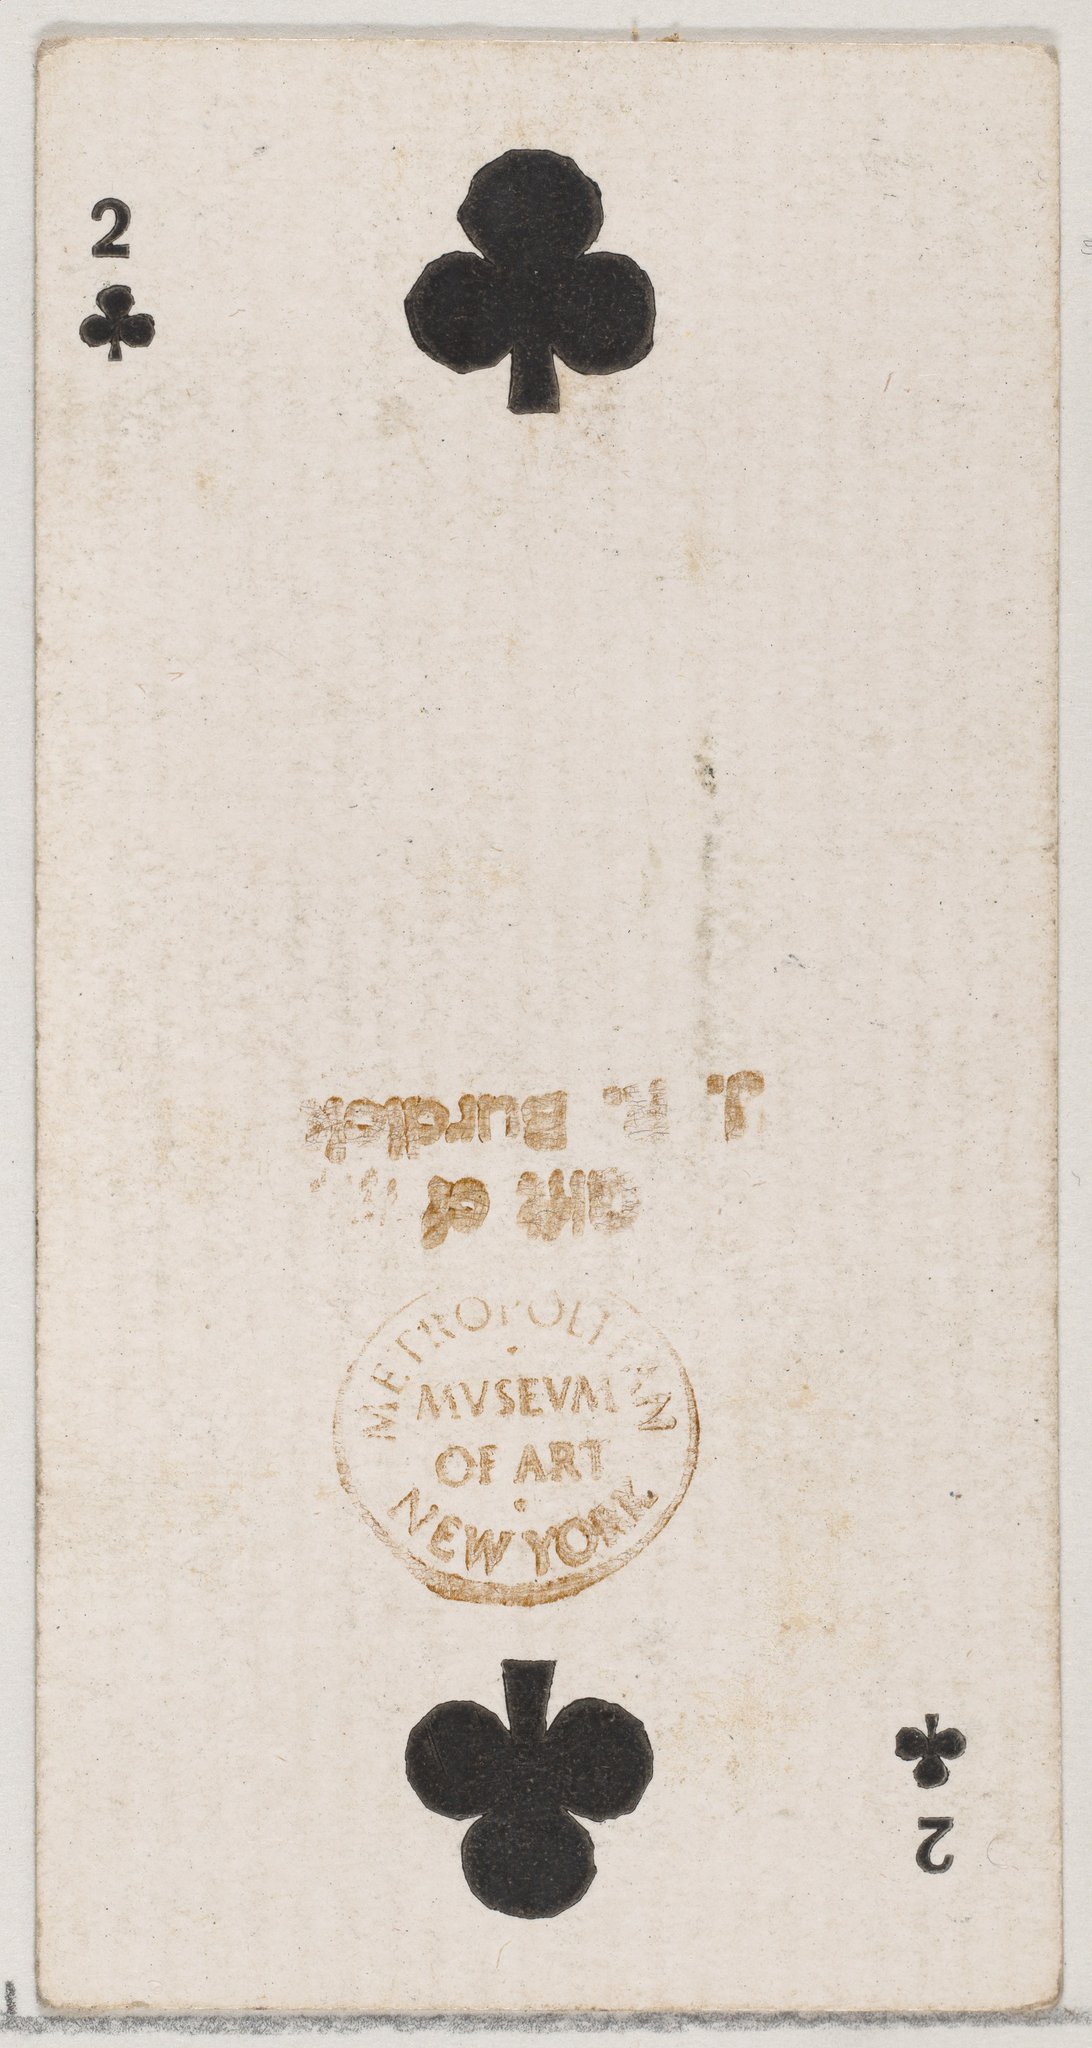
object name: print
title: Two of Clubs (black), from the Playing Cards series (N84) for Duke brand cigarettes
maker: w. duke, sons & co.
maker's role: publisher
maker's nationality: american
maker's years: 1870-1920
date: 1888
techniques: color lithograph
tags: playing cards